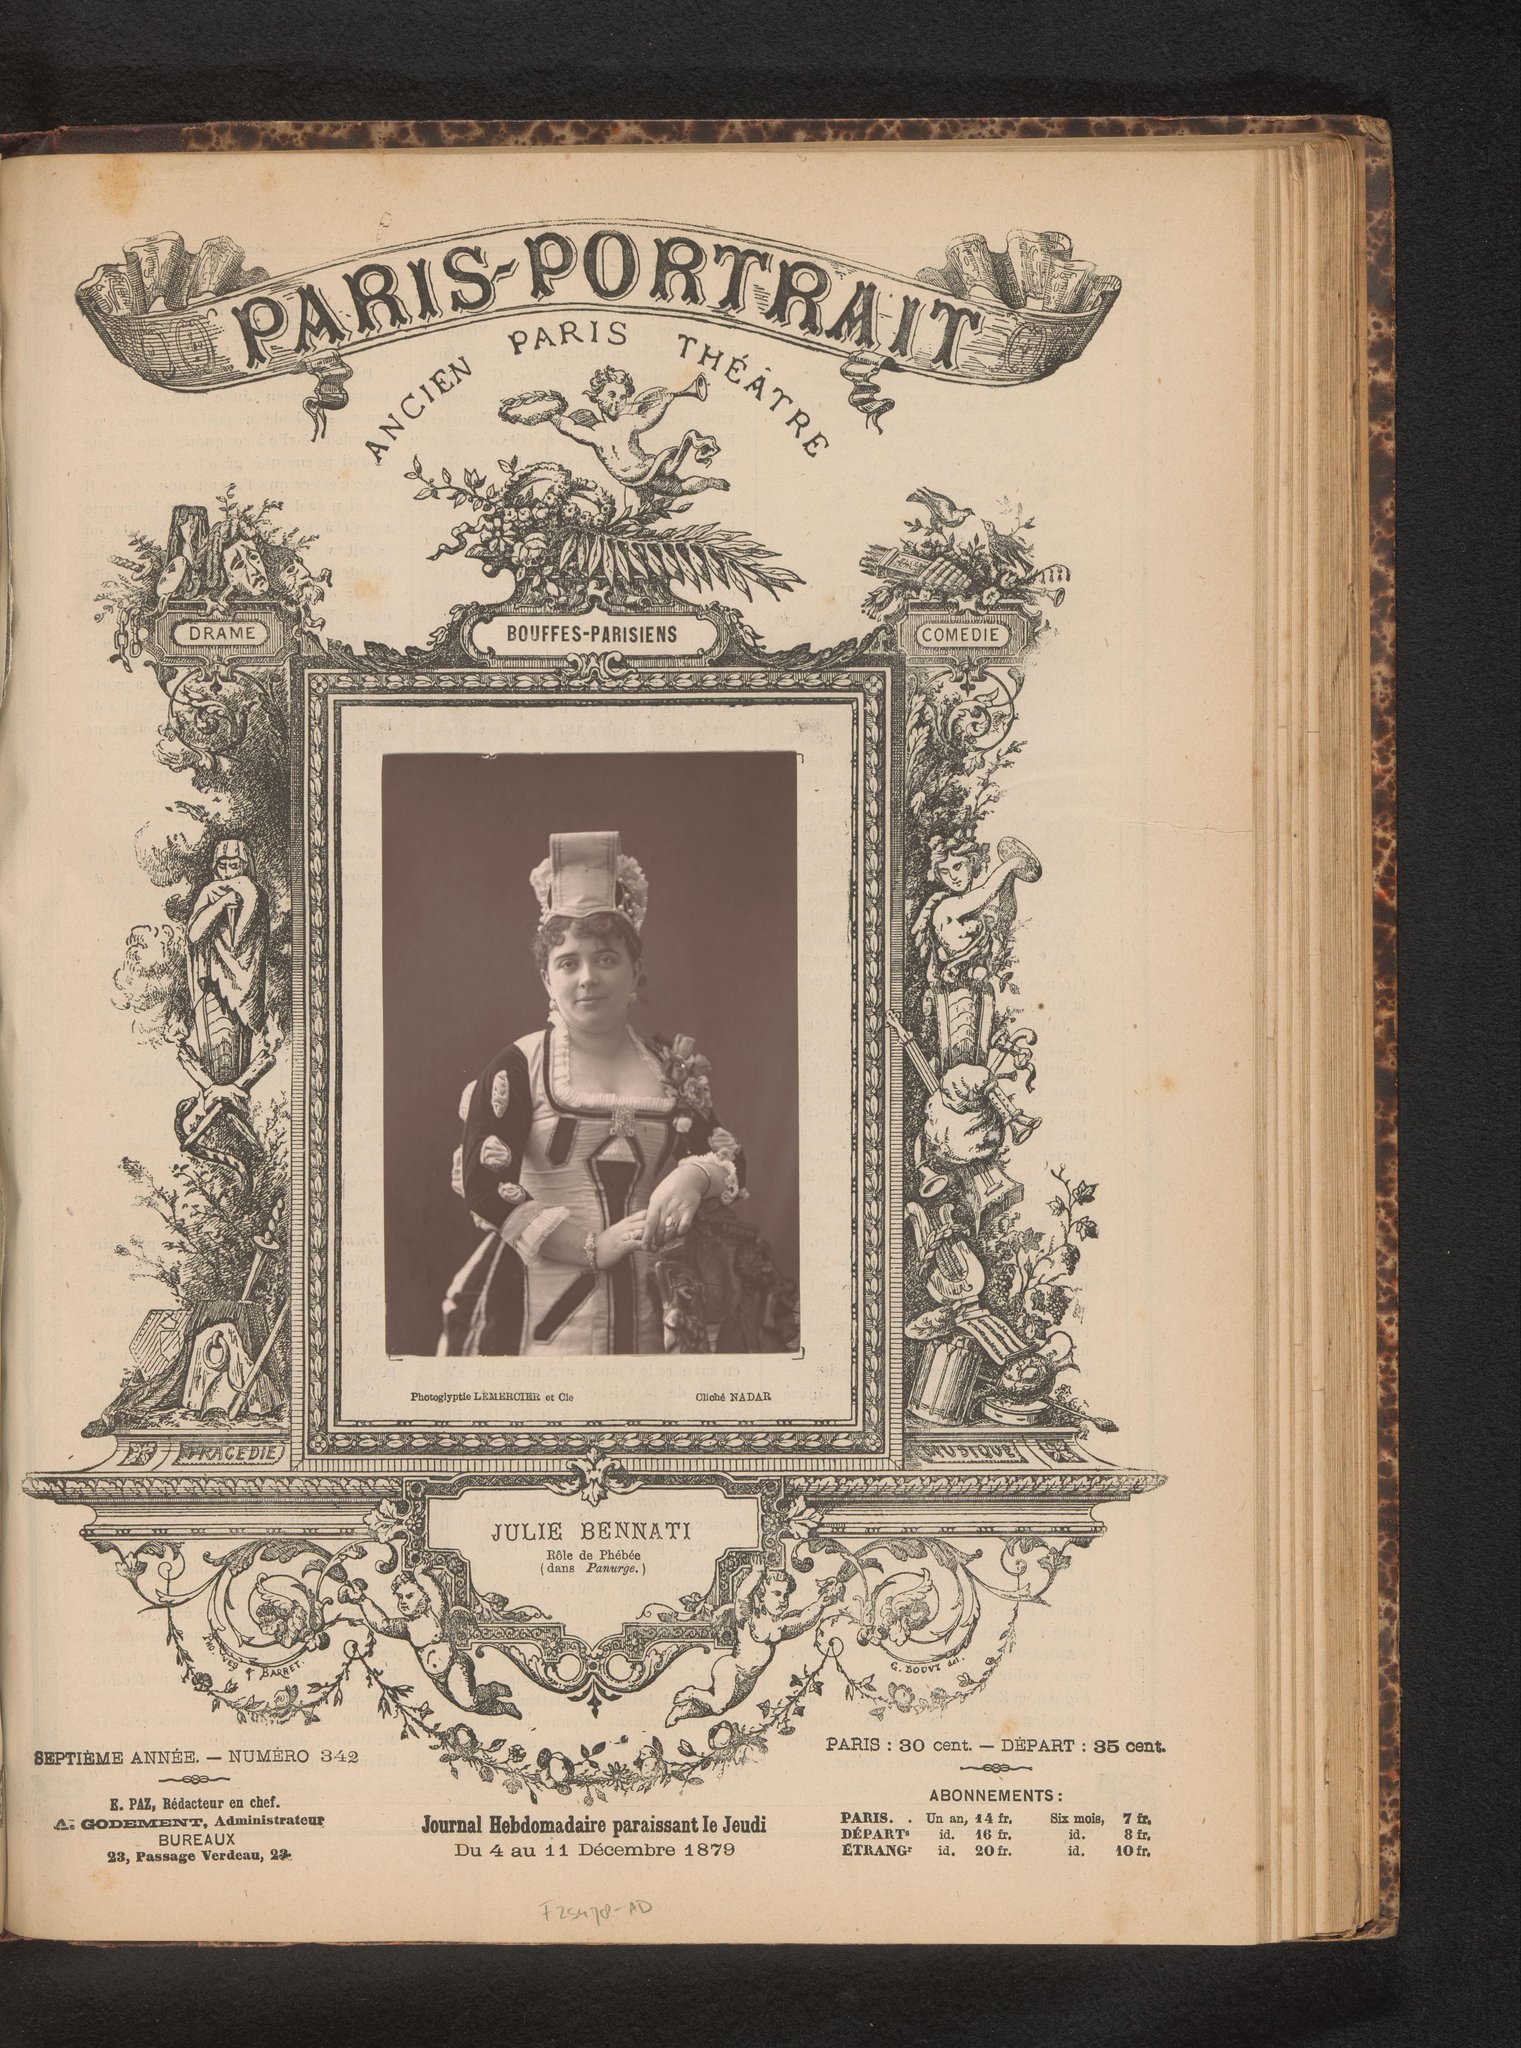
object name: photomechanical print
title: Portret van Julie Bennati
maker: félix nadar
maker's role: ballonvaarder, fotograaf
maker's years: 1820-1910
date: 1873-1880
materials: paper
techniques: woodburytype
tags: historical persons - bb - woman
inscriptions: inscription: ‘Rôle de Phébée (dans Panurge)’